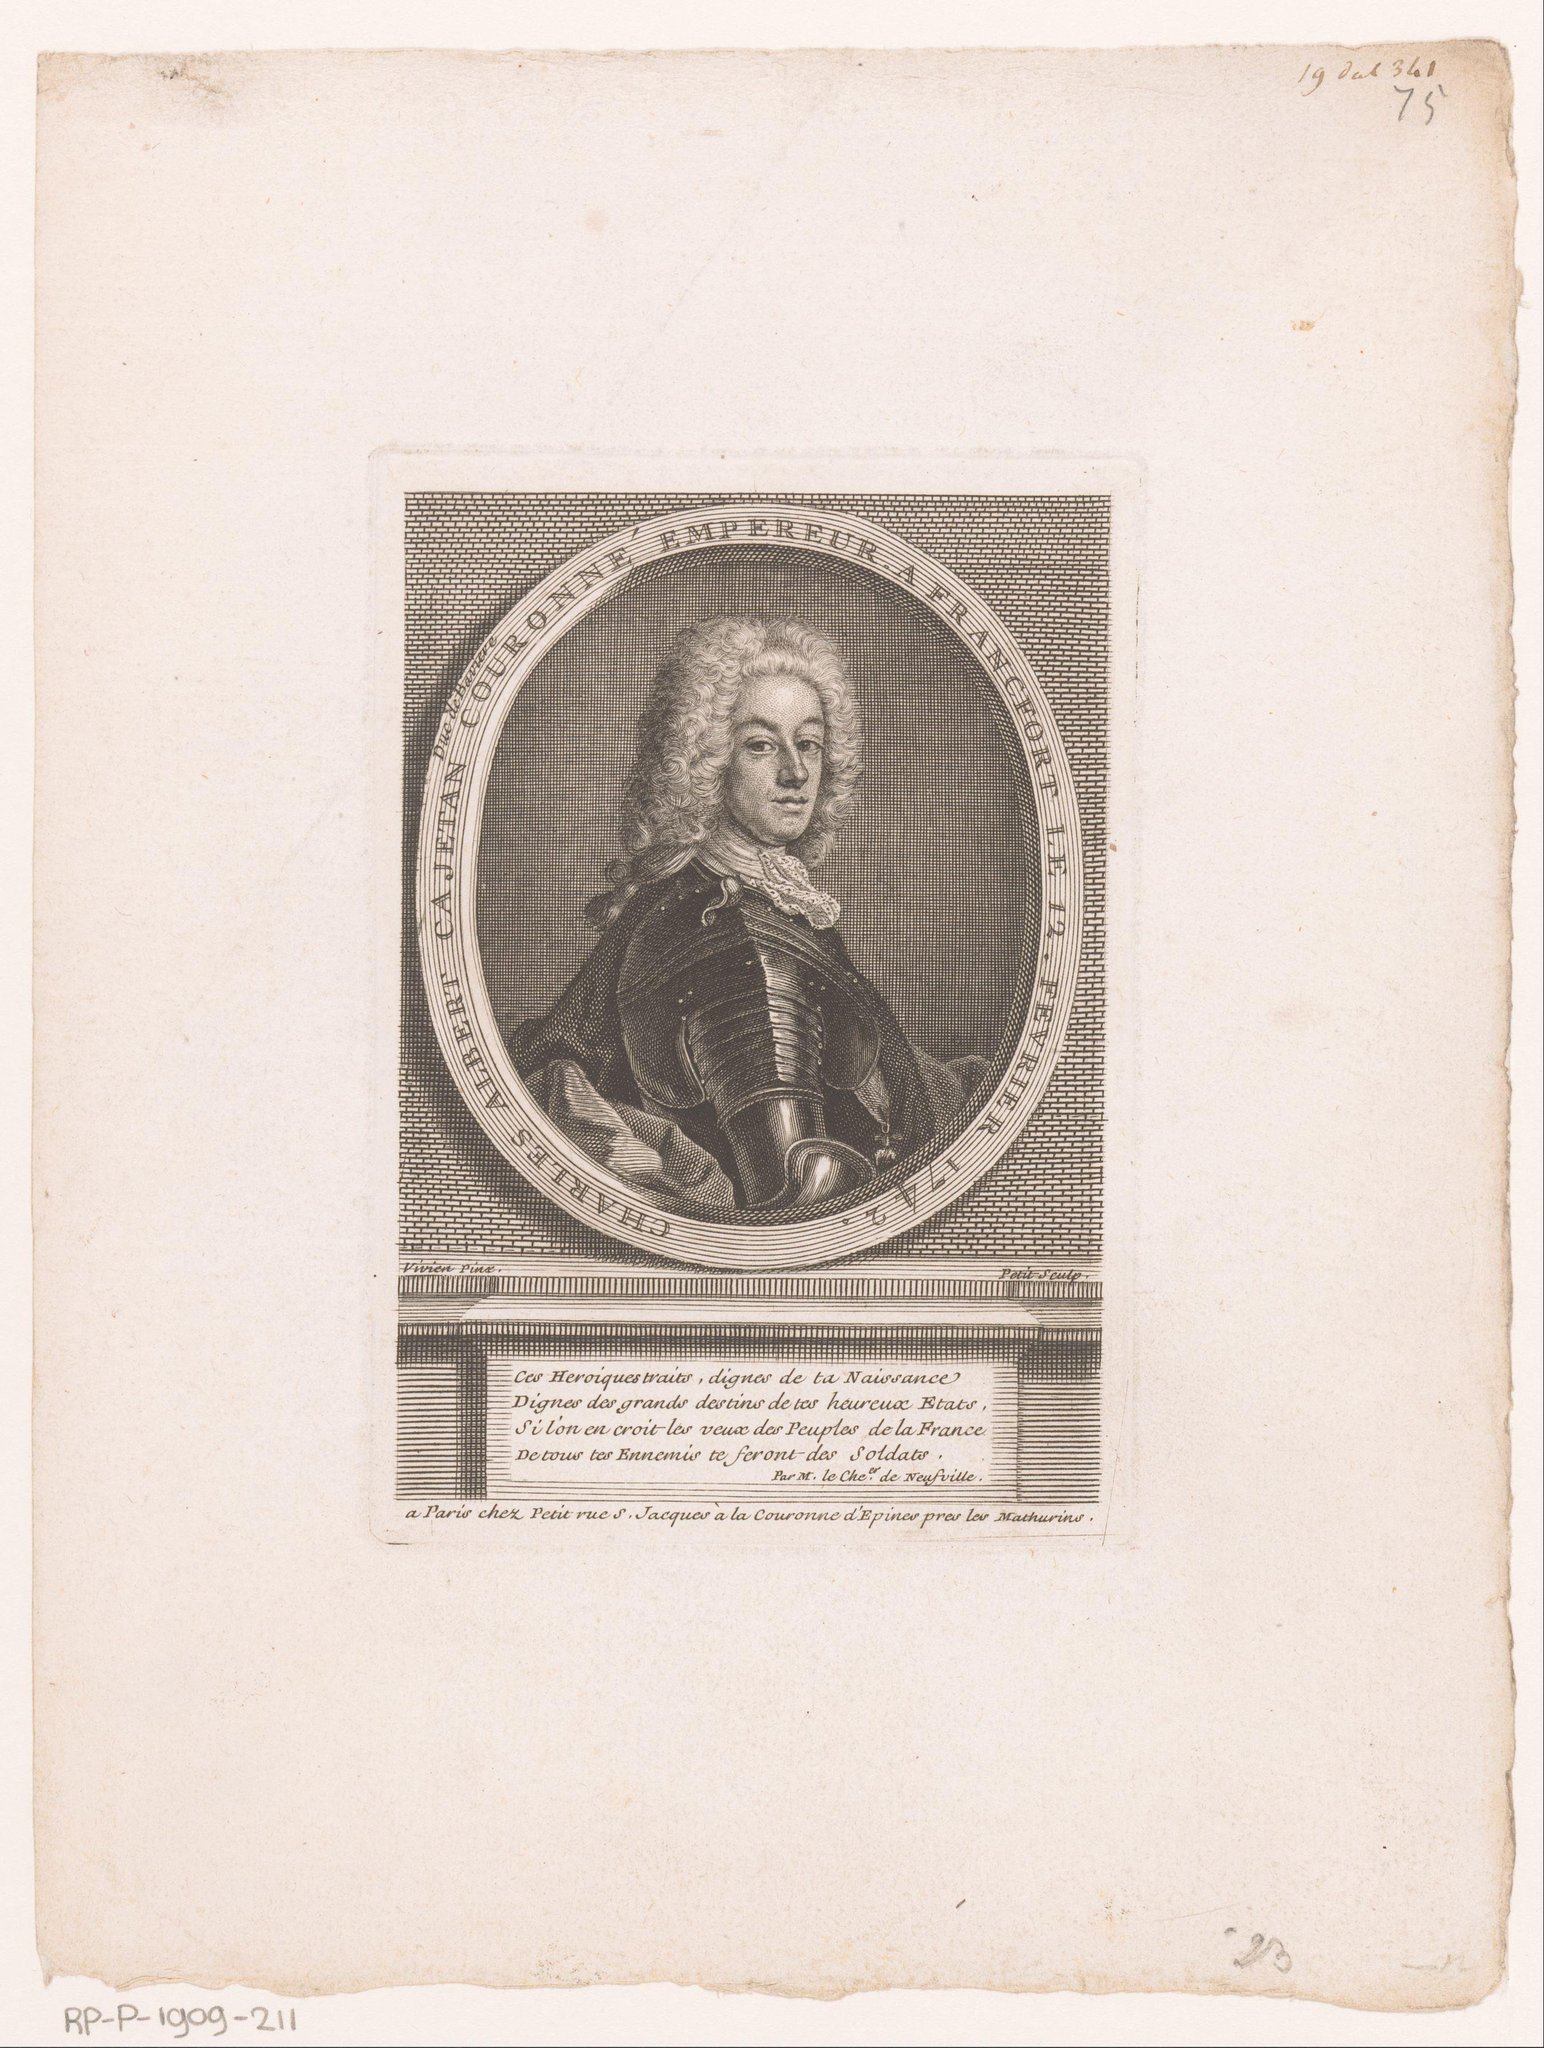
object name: print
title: Portret van Karel VII Albrecht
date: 1742-1760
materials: paper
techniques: engraving, etching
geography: paris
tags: brussels, karel vii albrecht (duits keizer), historical persons, emperor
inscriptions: collector's mark: Lugt 2228